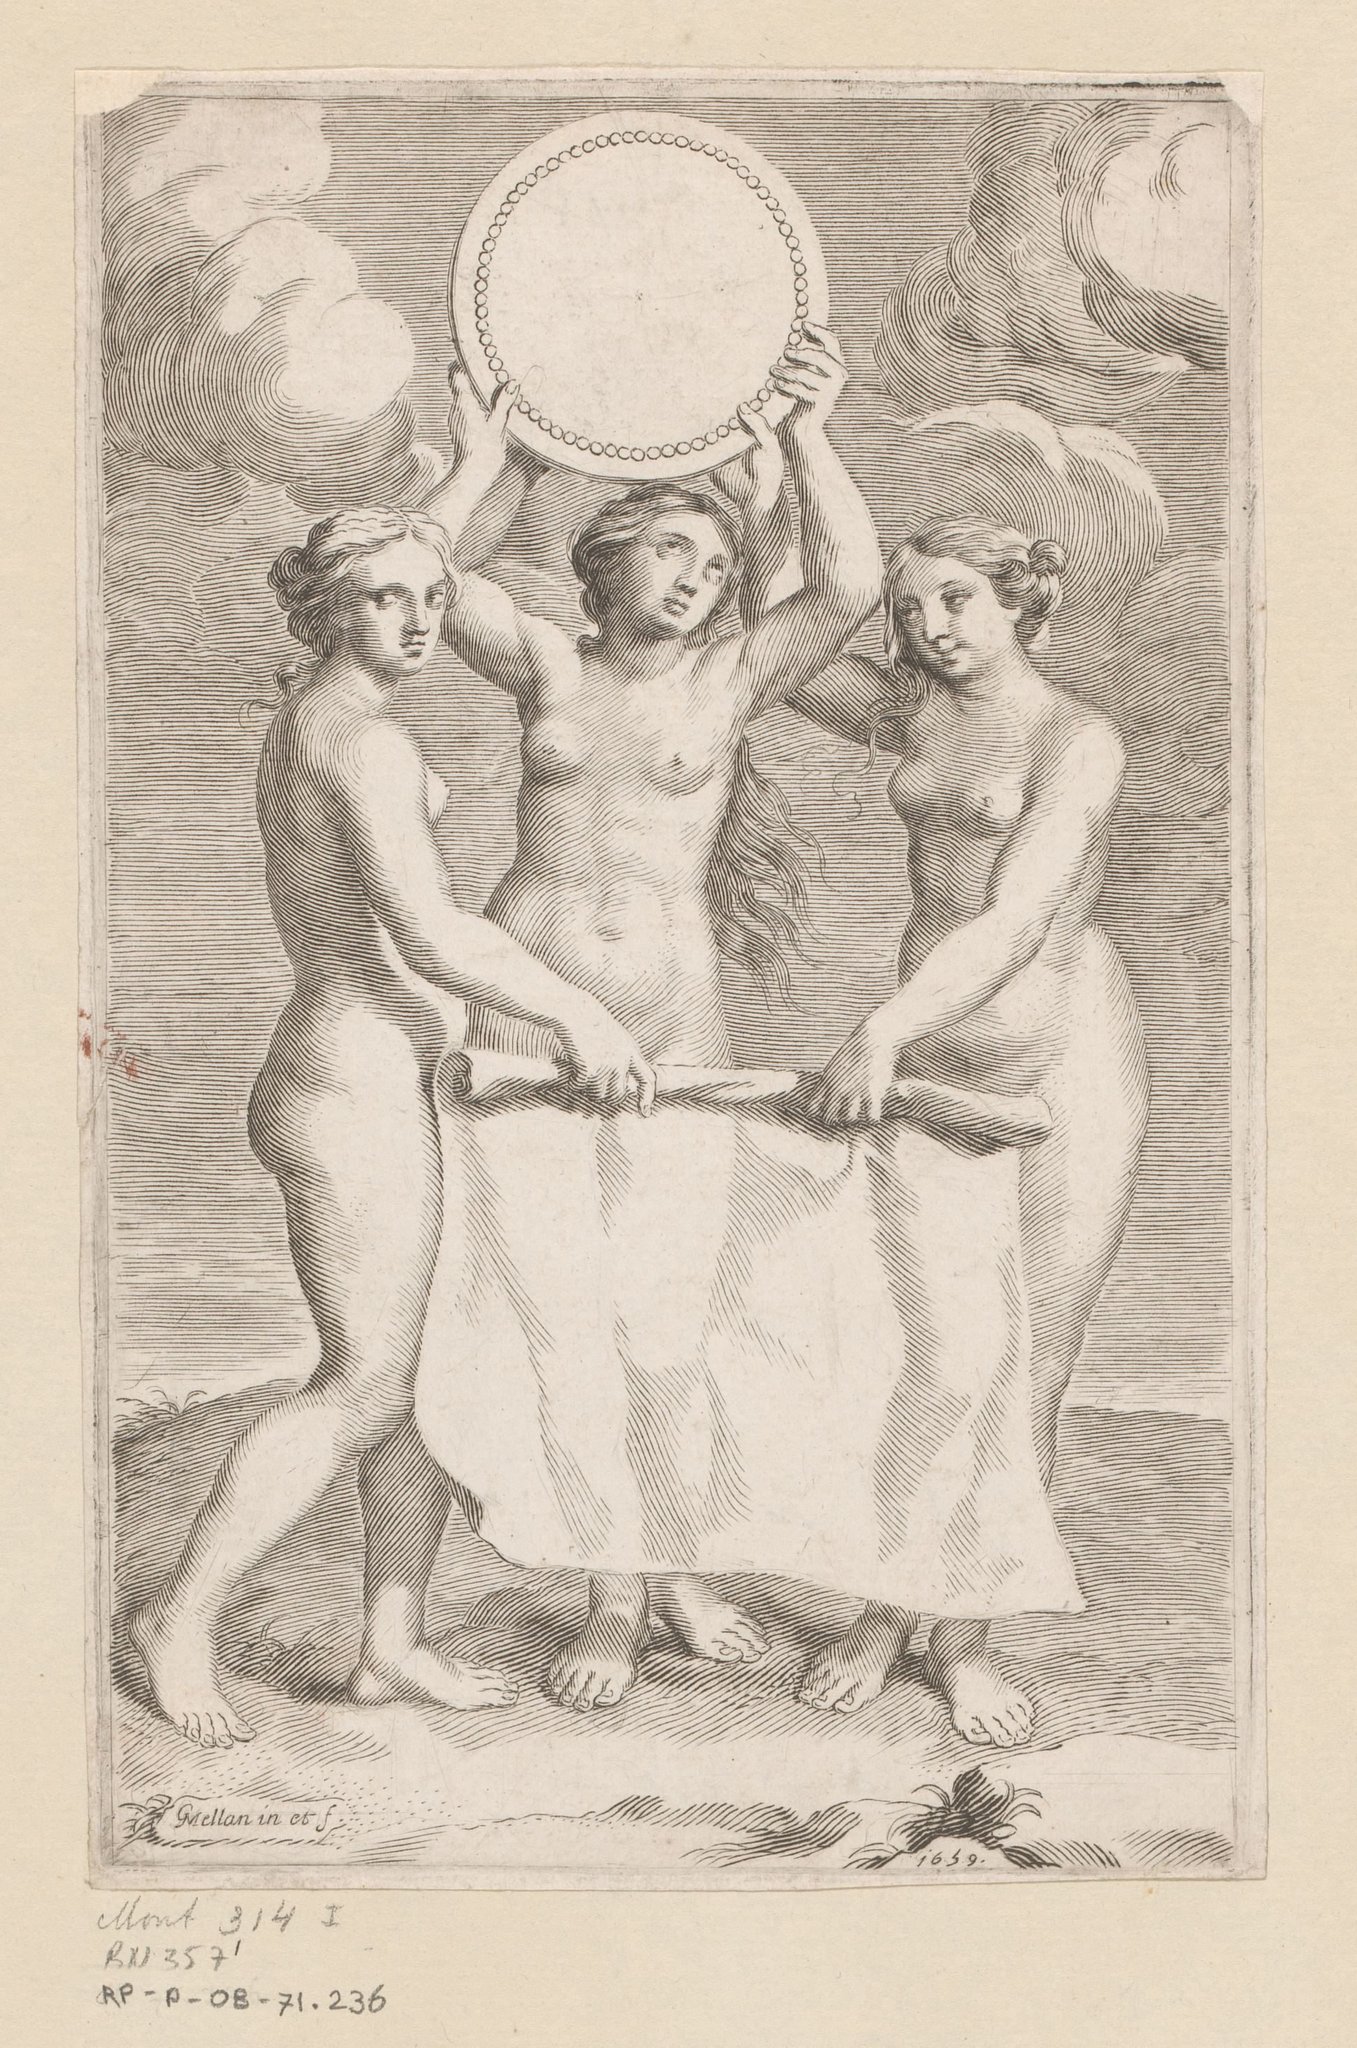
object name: print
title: Drie Gratiën met een medaillon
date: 1659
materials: paper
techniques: engraving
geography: france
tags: ornament ~ medallion, graces (charites), generally three in number; 'gratie' (ripa)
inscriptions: collector's mark: Lugt 240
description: Titelpagina voor: Vias, Balthazar de. Charitum libri tres. Parijs: Edmond Martin, 1660.